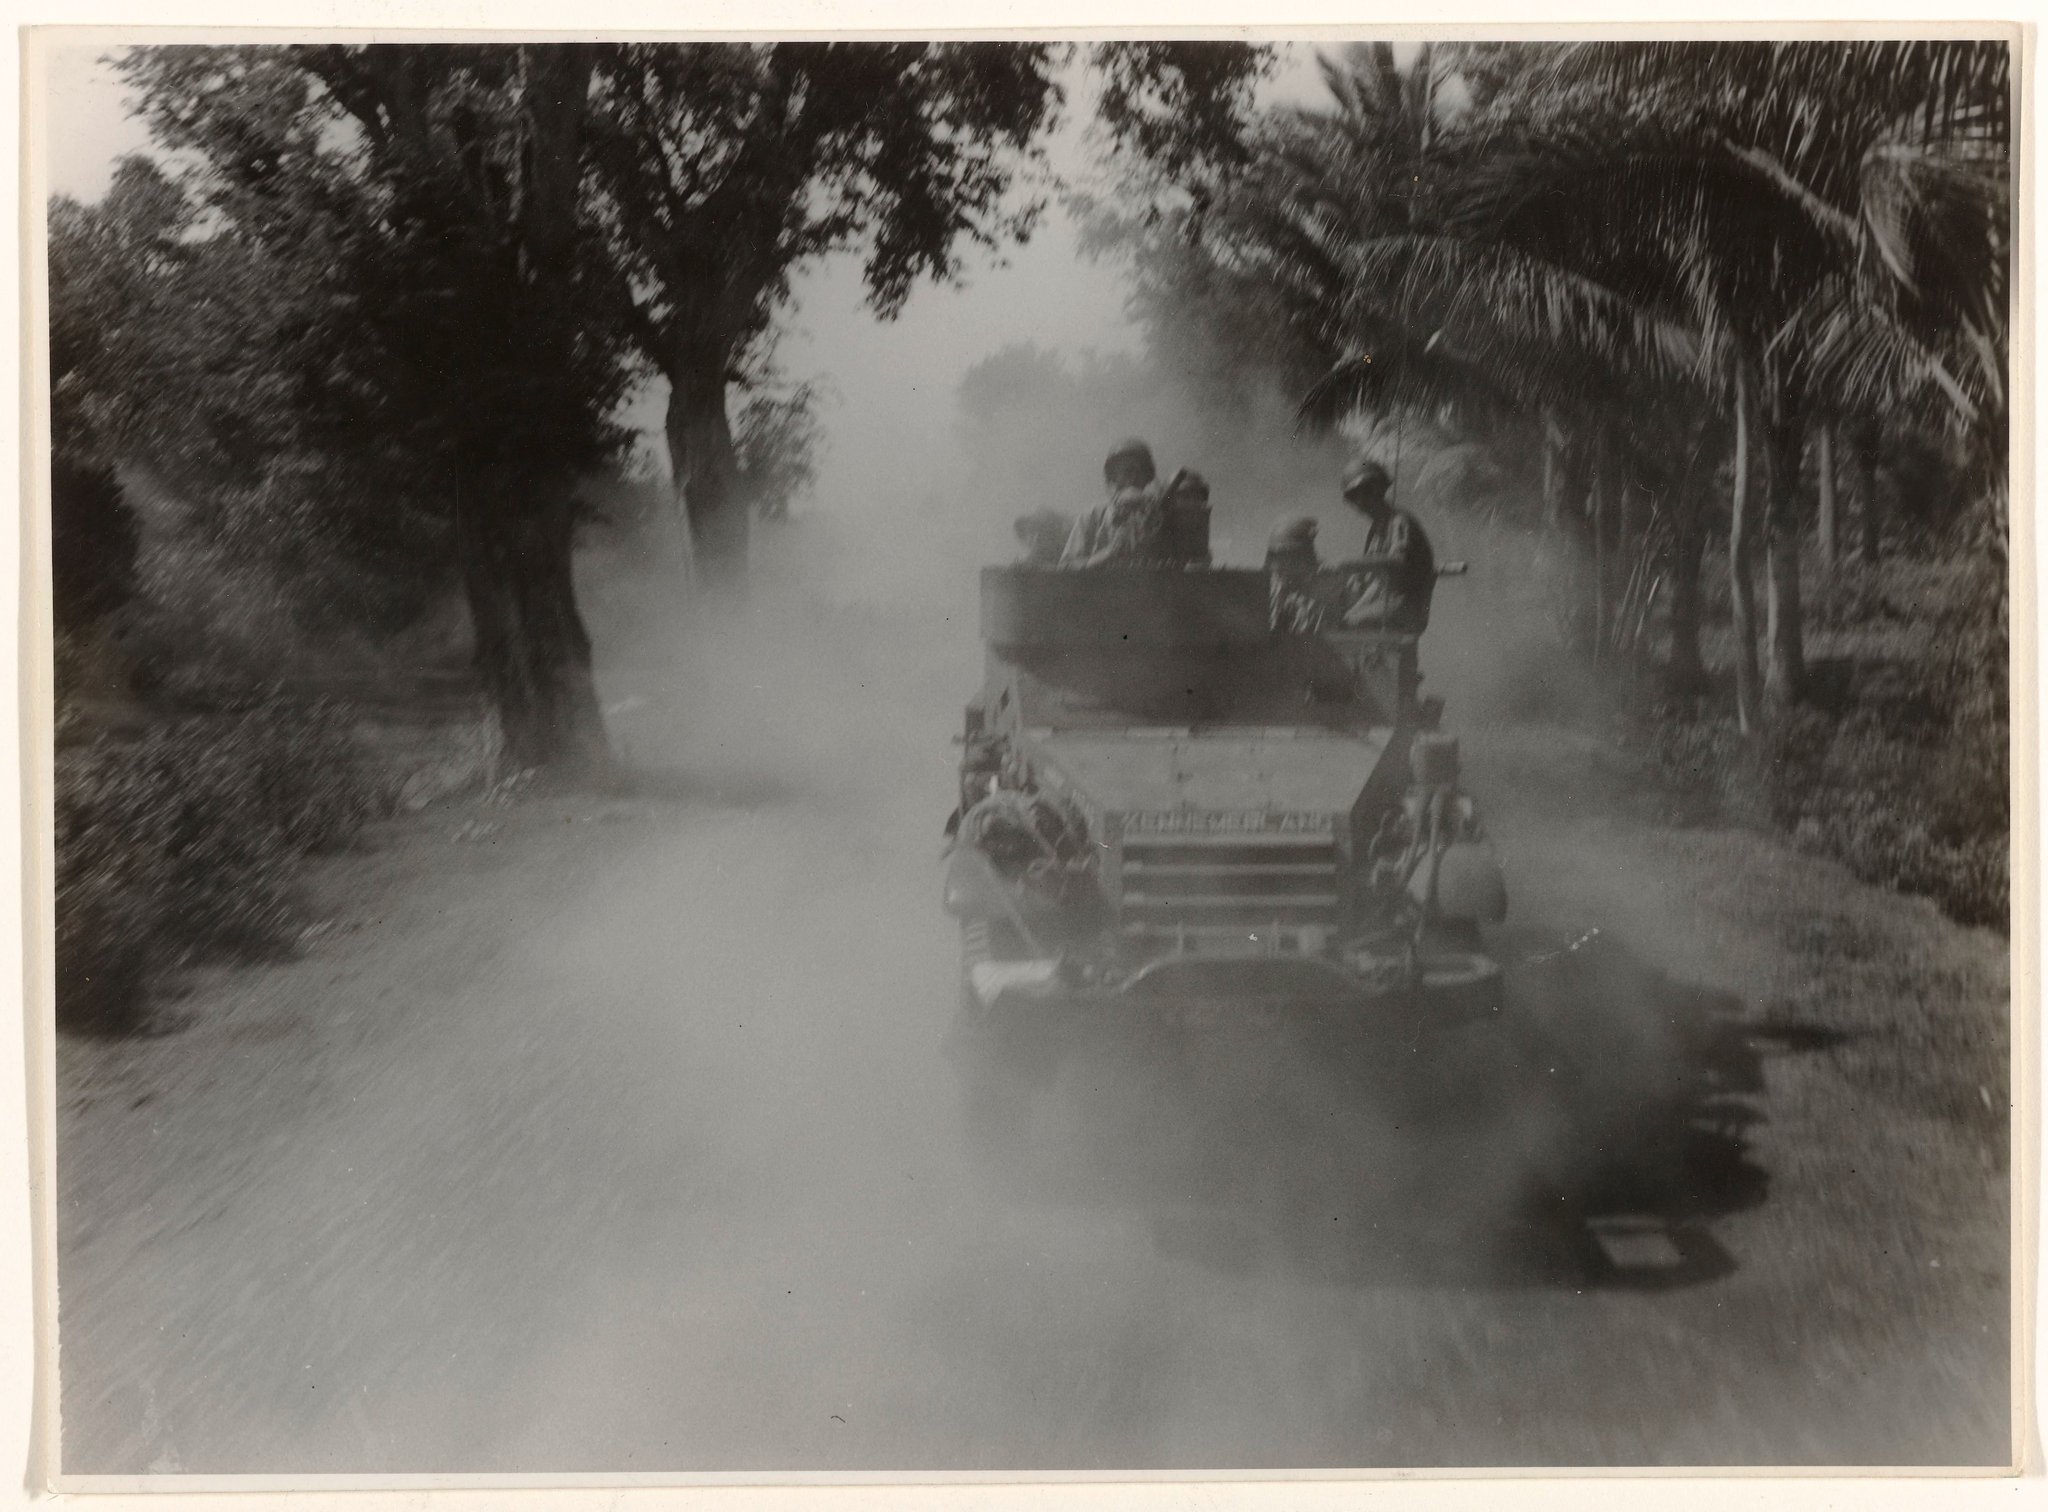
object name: photograph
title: Verkenningsafdeling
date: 1947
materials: photographic support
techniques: photography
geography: java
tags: guerilla warfare, java, dutch east indies, the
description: Een verkenningsafdeling van de Mariniers rijdt in een pantserwagen tijdens de opmars naar Probolinggo, 21 jui 1947.